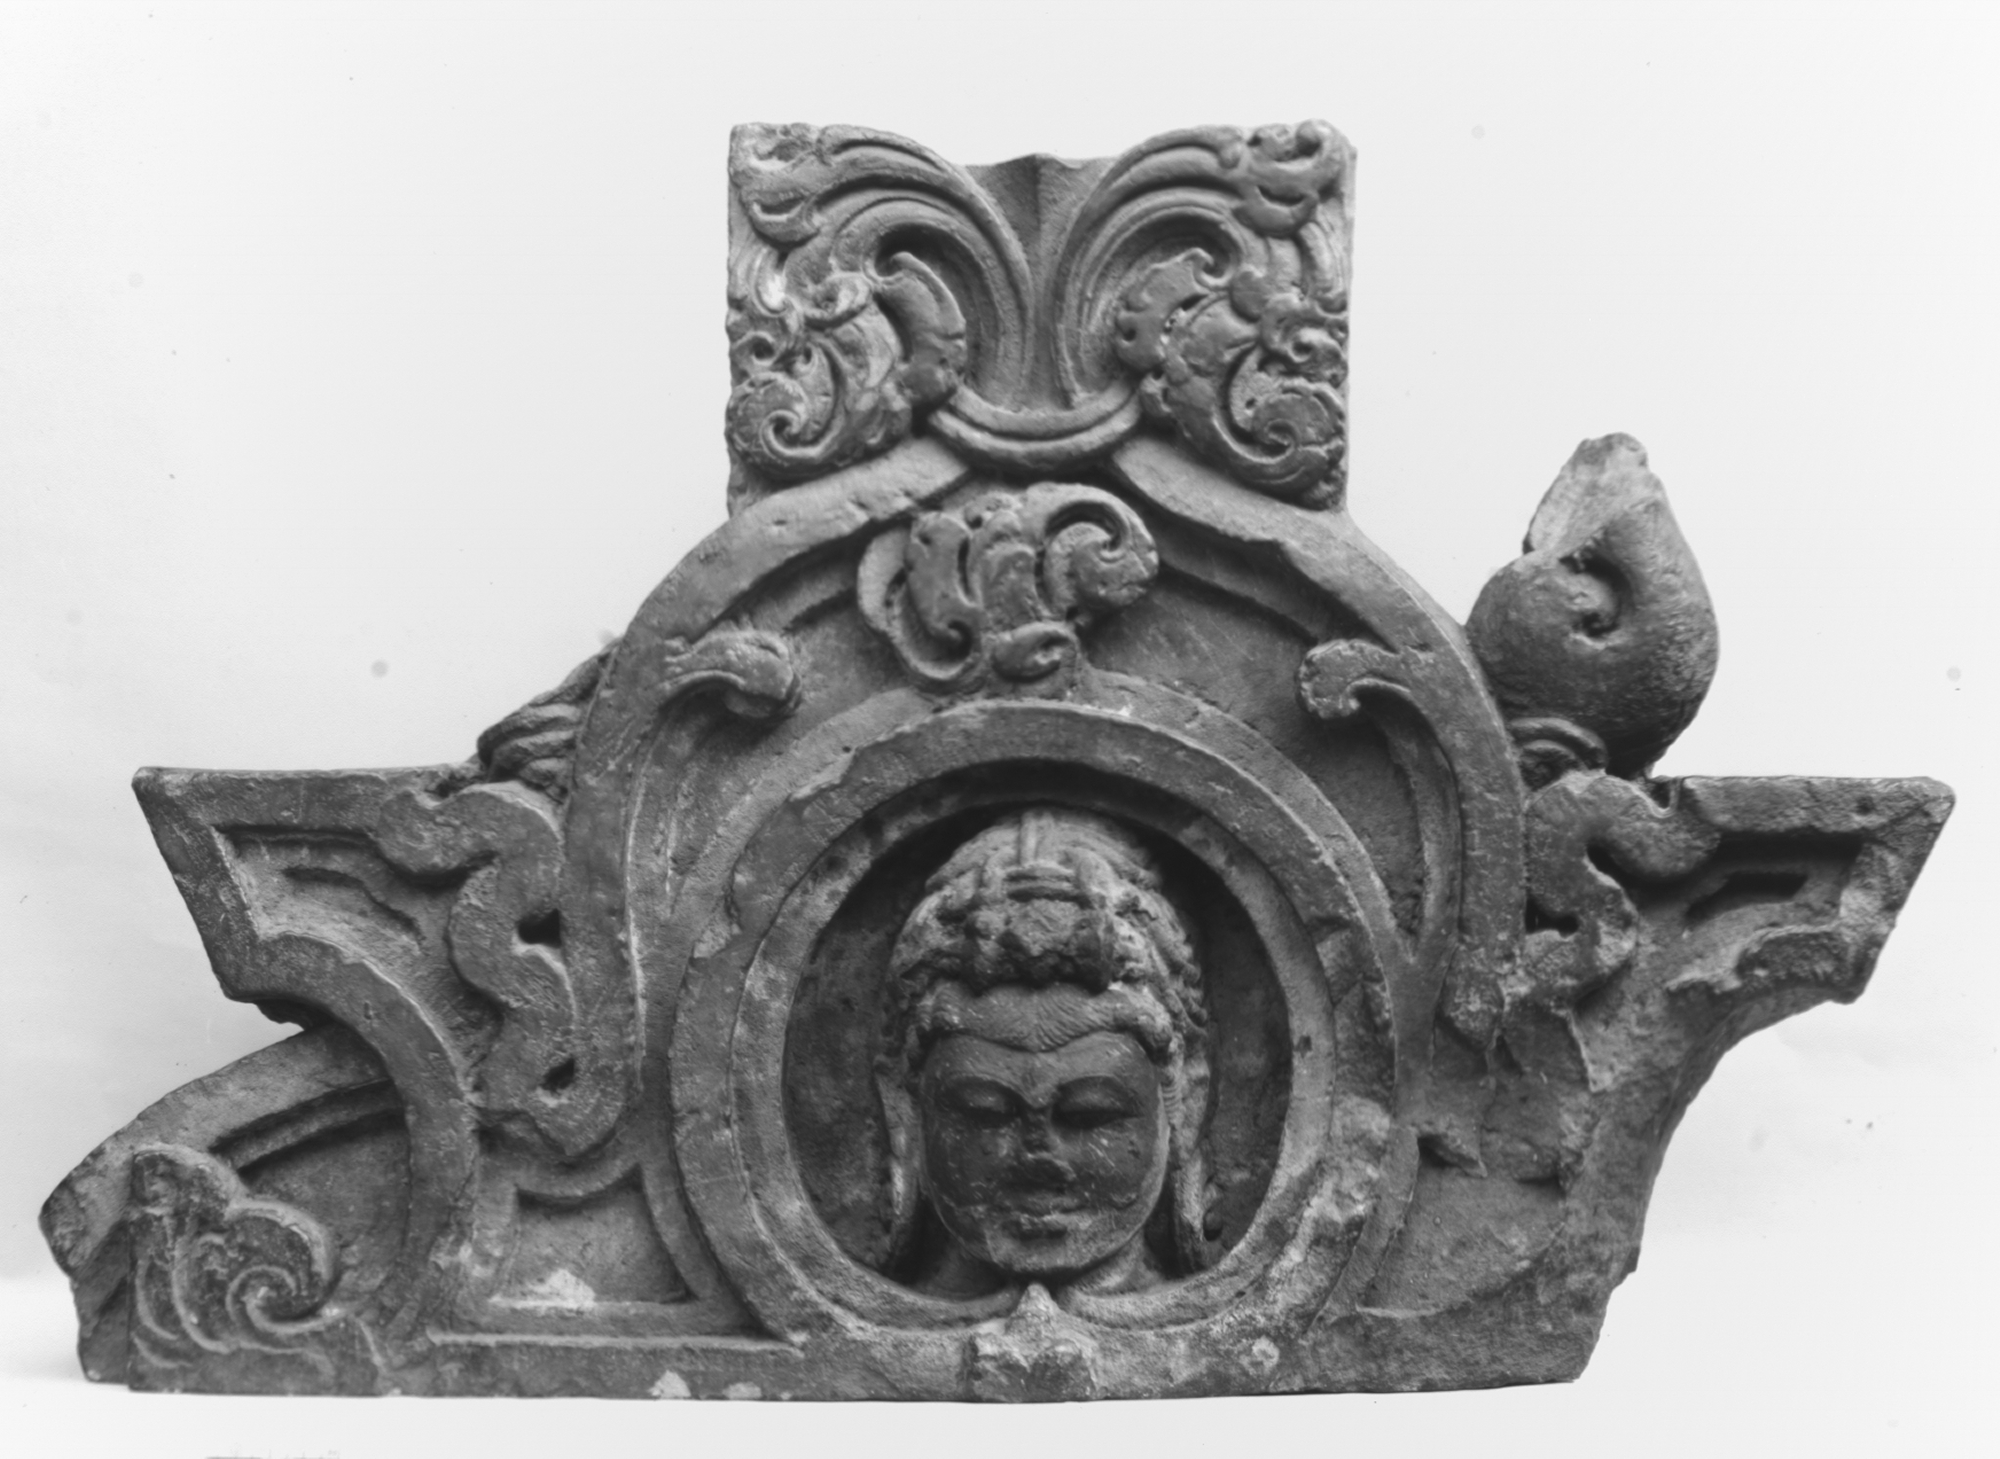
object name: relief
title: Head of a Hindu Deity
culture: indian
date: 801-900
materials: stone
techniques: painting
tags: heads,hinduism